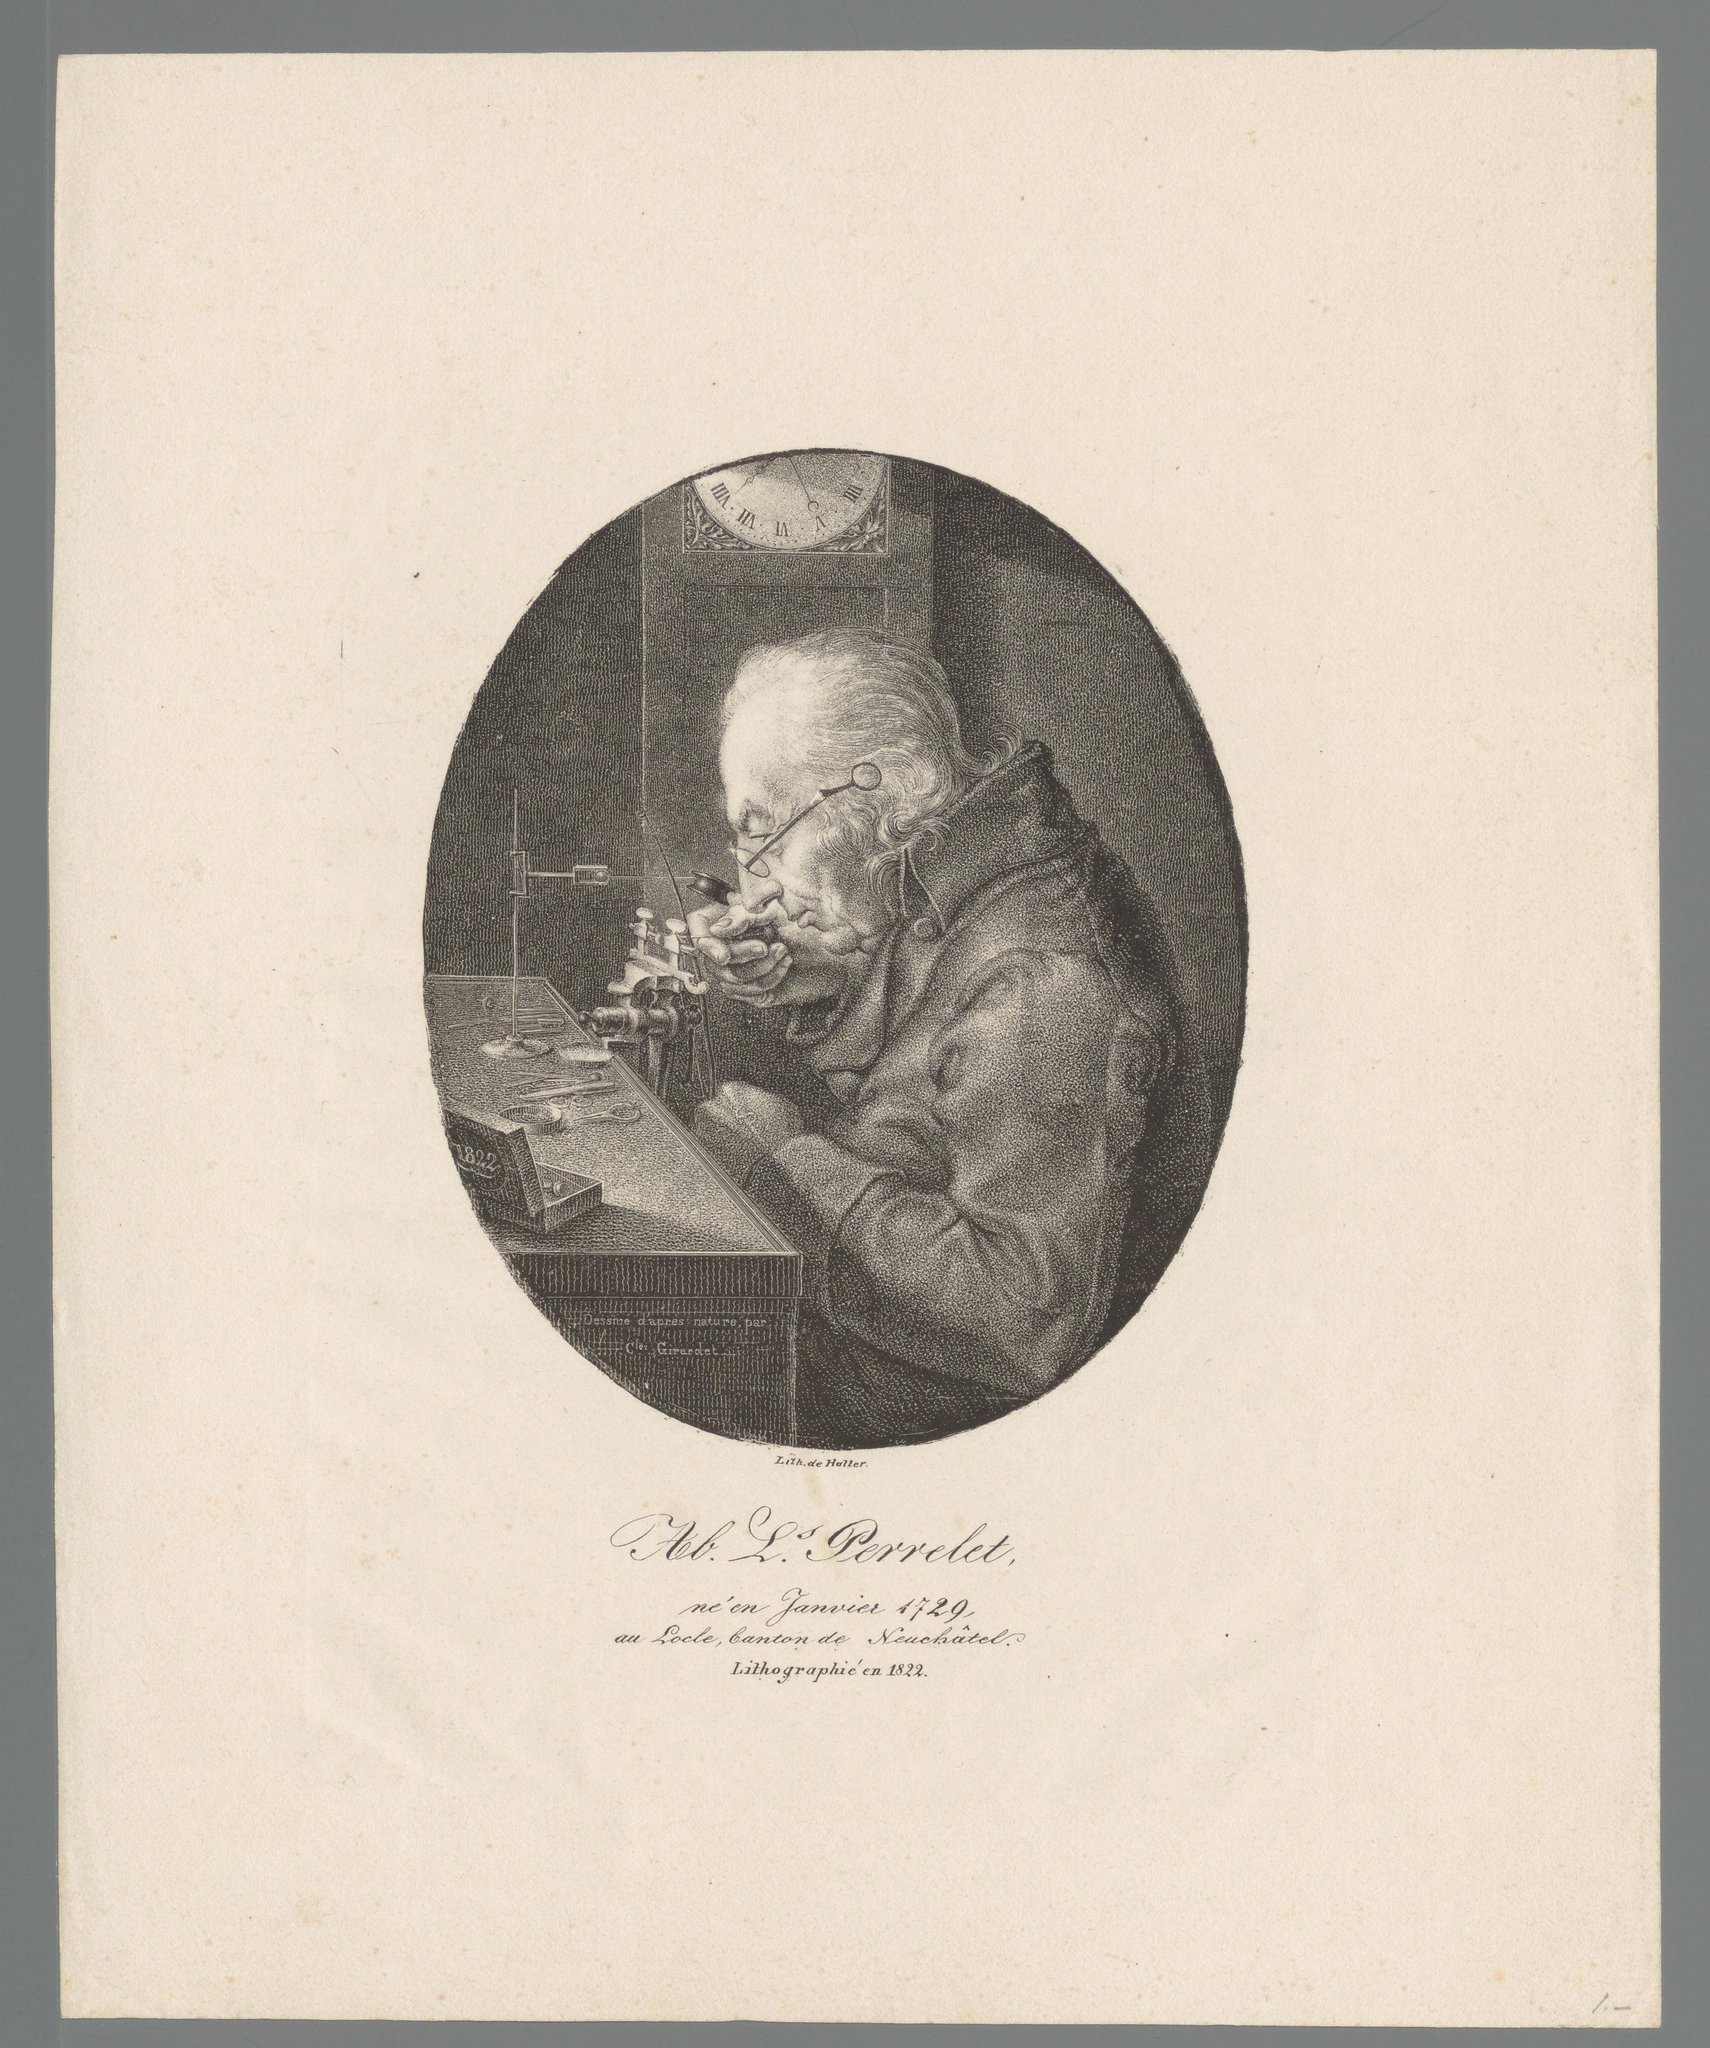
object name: print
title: Portret van Abraham-Louis Perrelet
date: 1822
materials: paper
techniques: lithograph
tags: clockmaker, historical persons, clock, watchmaker, clockmaker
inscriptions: collector's mark: Lugt 2228